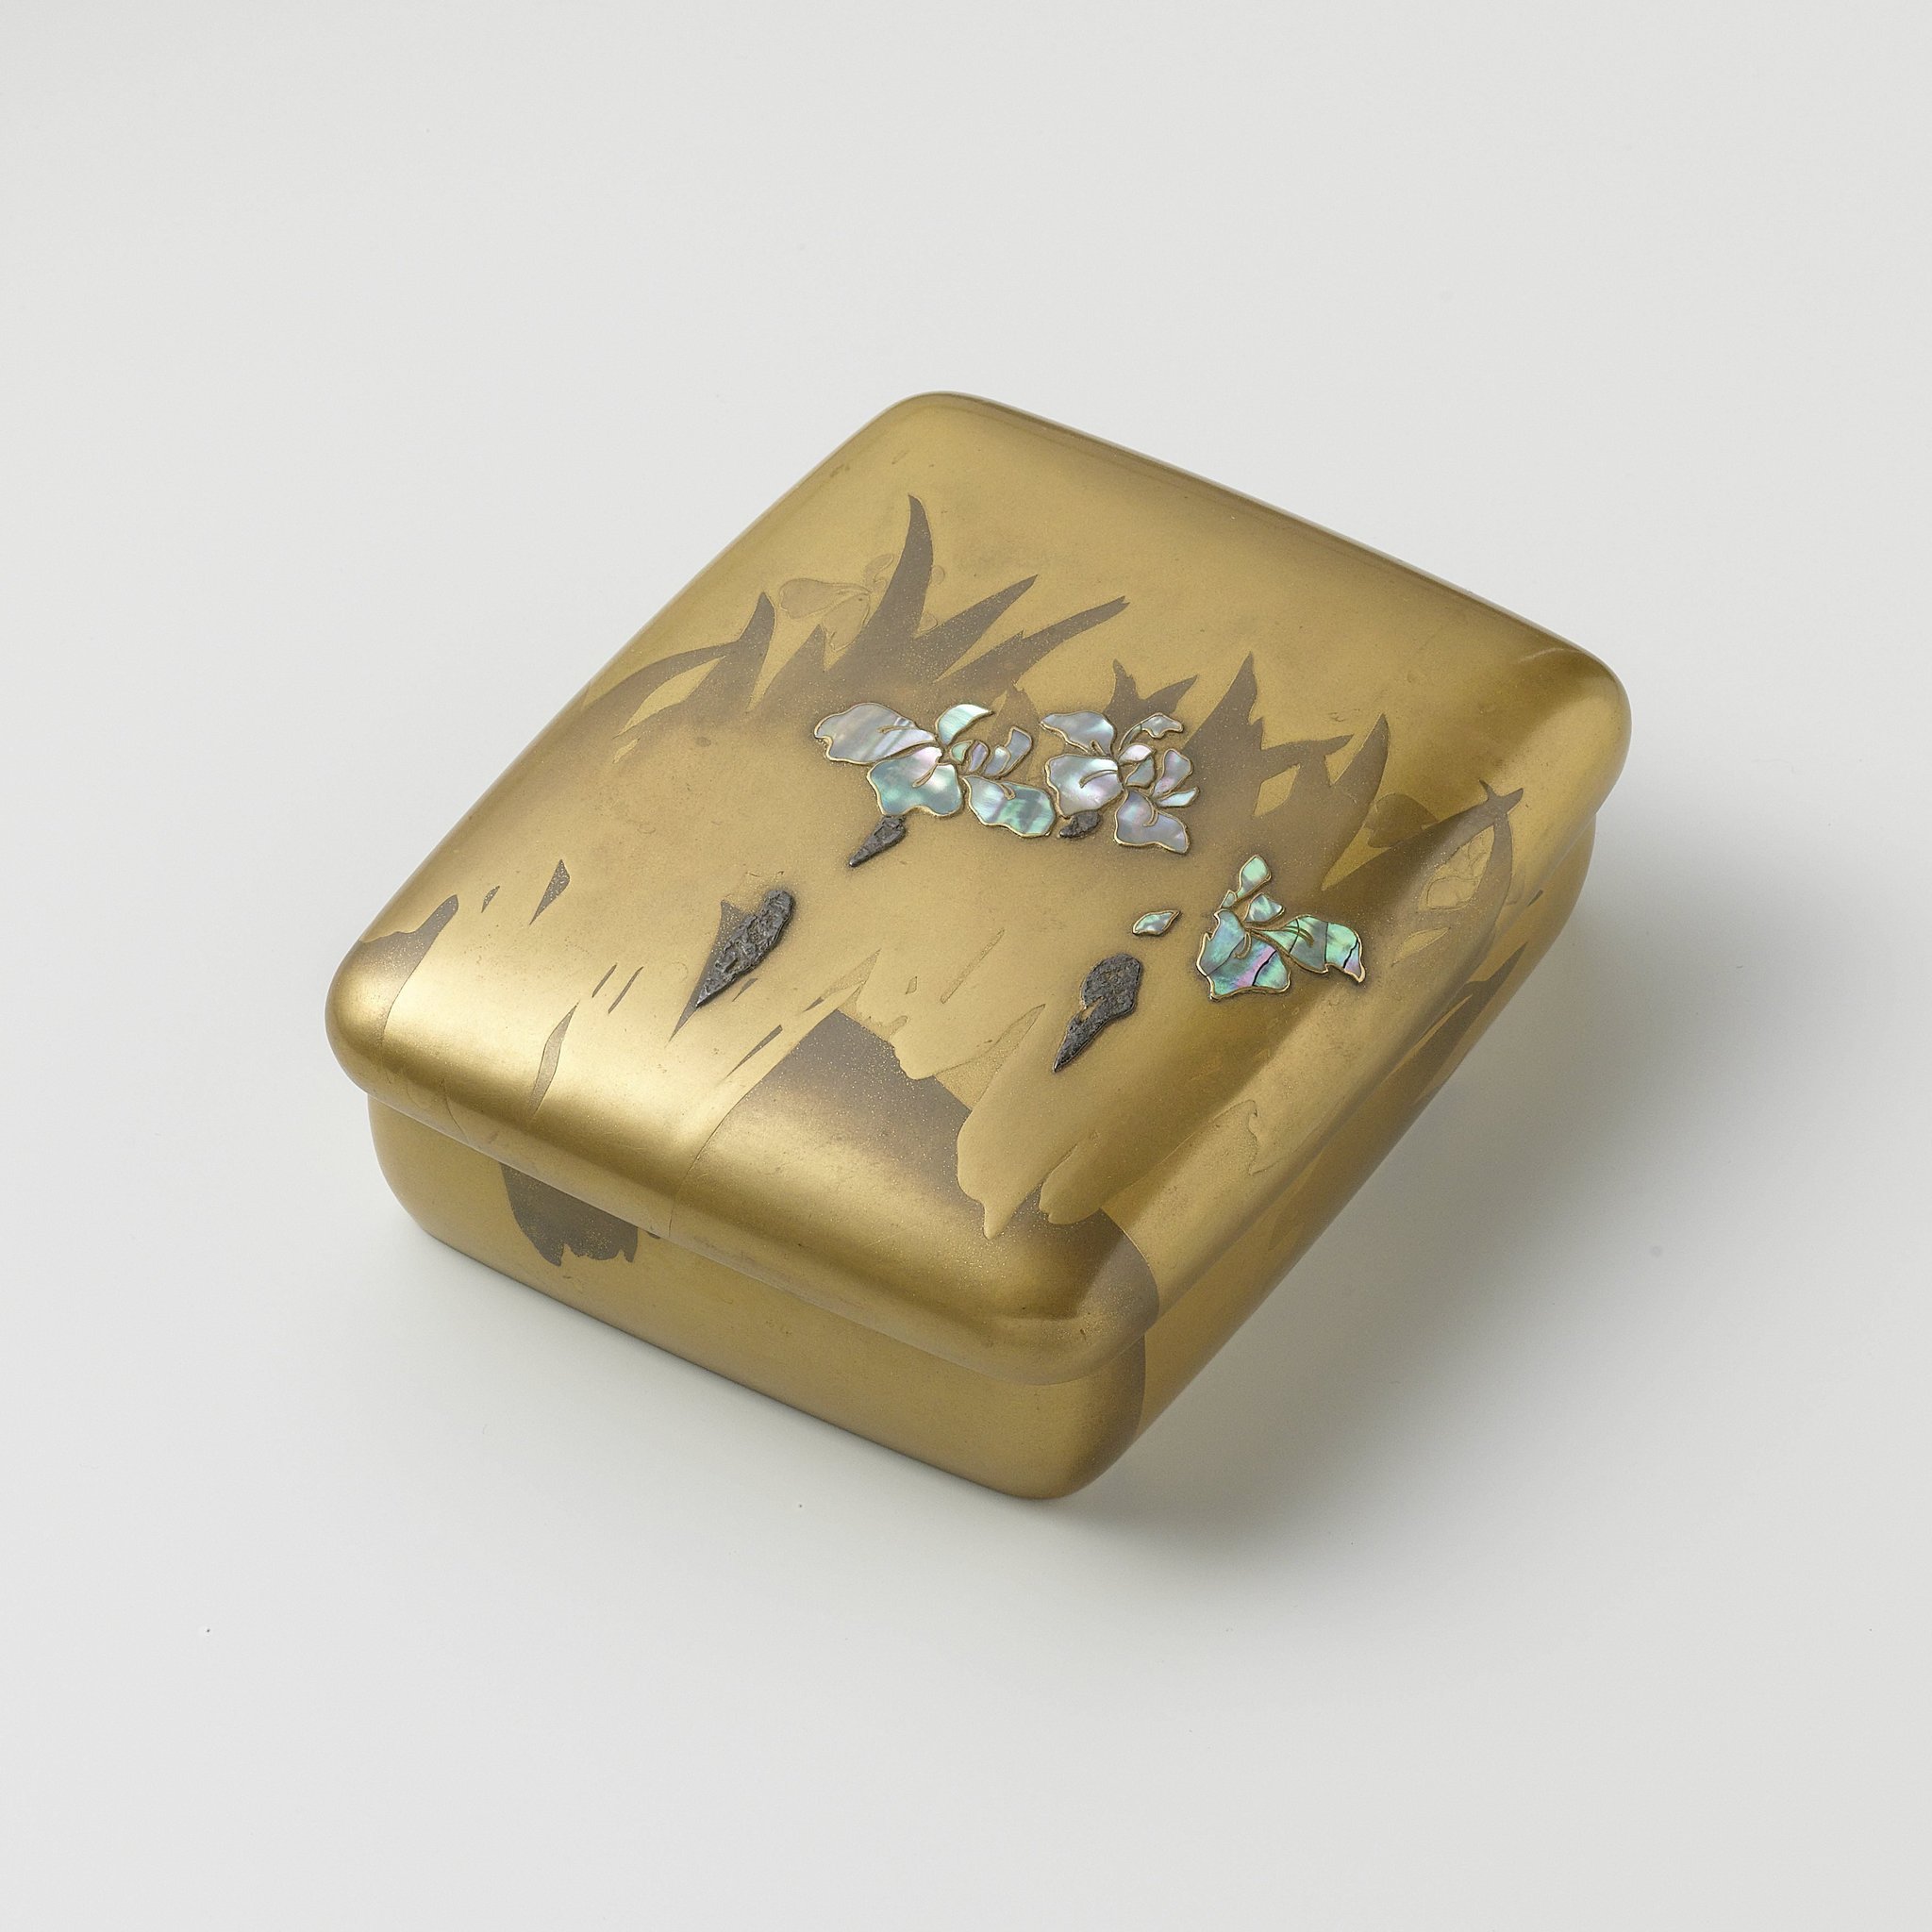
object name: box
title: Doos van goudlak, versierd met paarse irissen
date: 1868-1912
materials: lacquer, lead, mother of pearl, wood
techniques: inlay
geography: japan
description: Doos van goudlak versierd met paarse irissen.